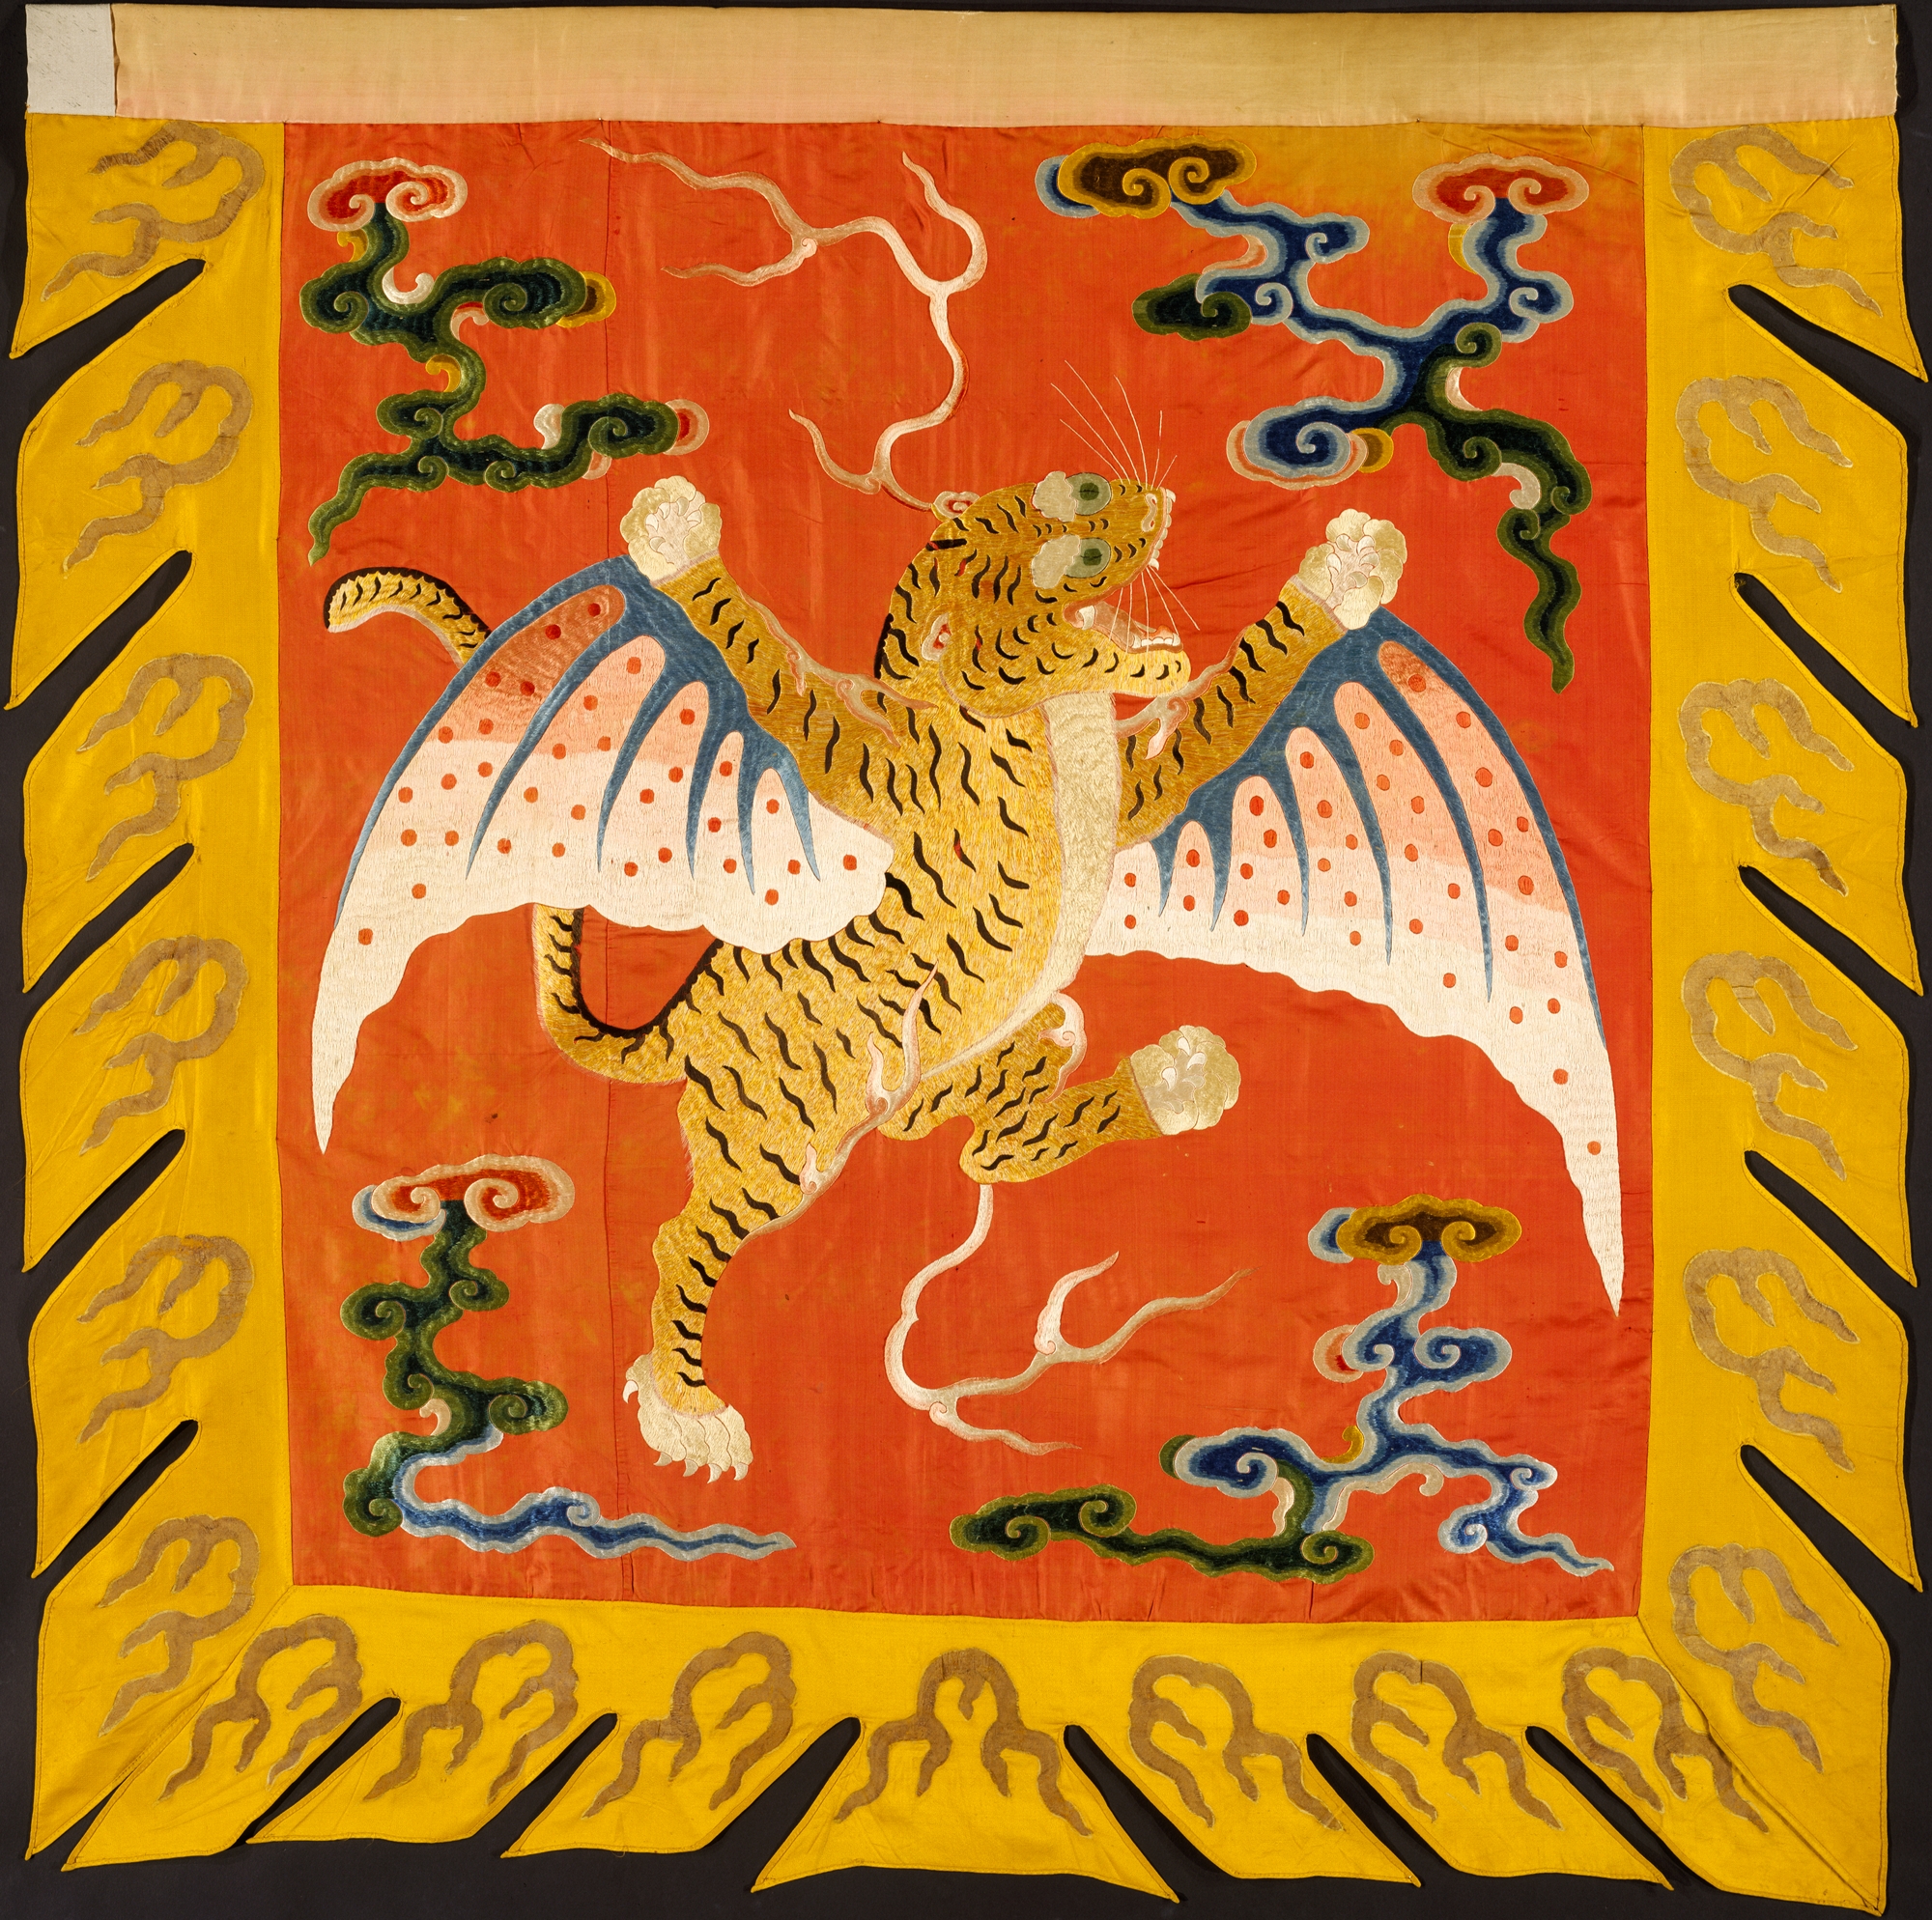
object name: banner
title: Banner (one of a pair)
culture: chinese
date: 1801-1900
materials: gold, silk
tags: flags